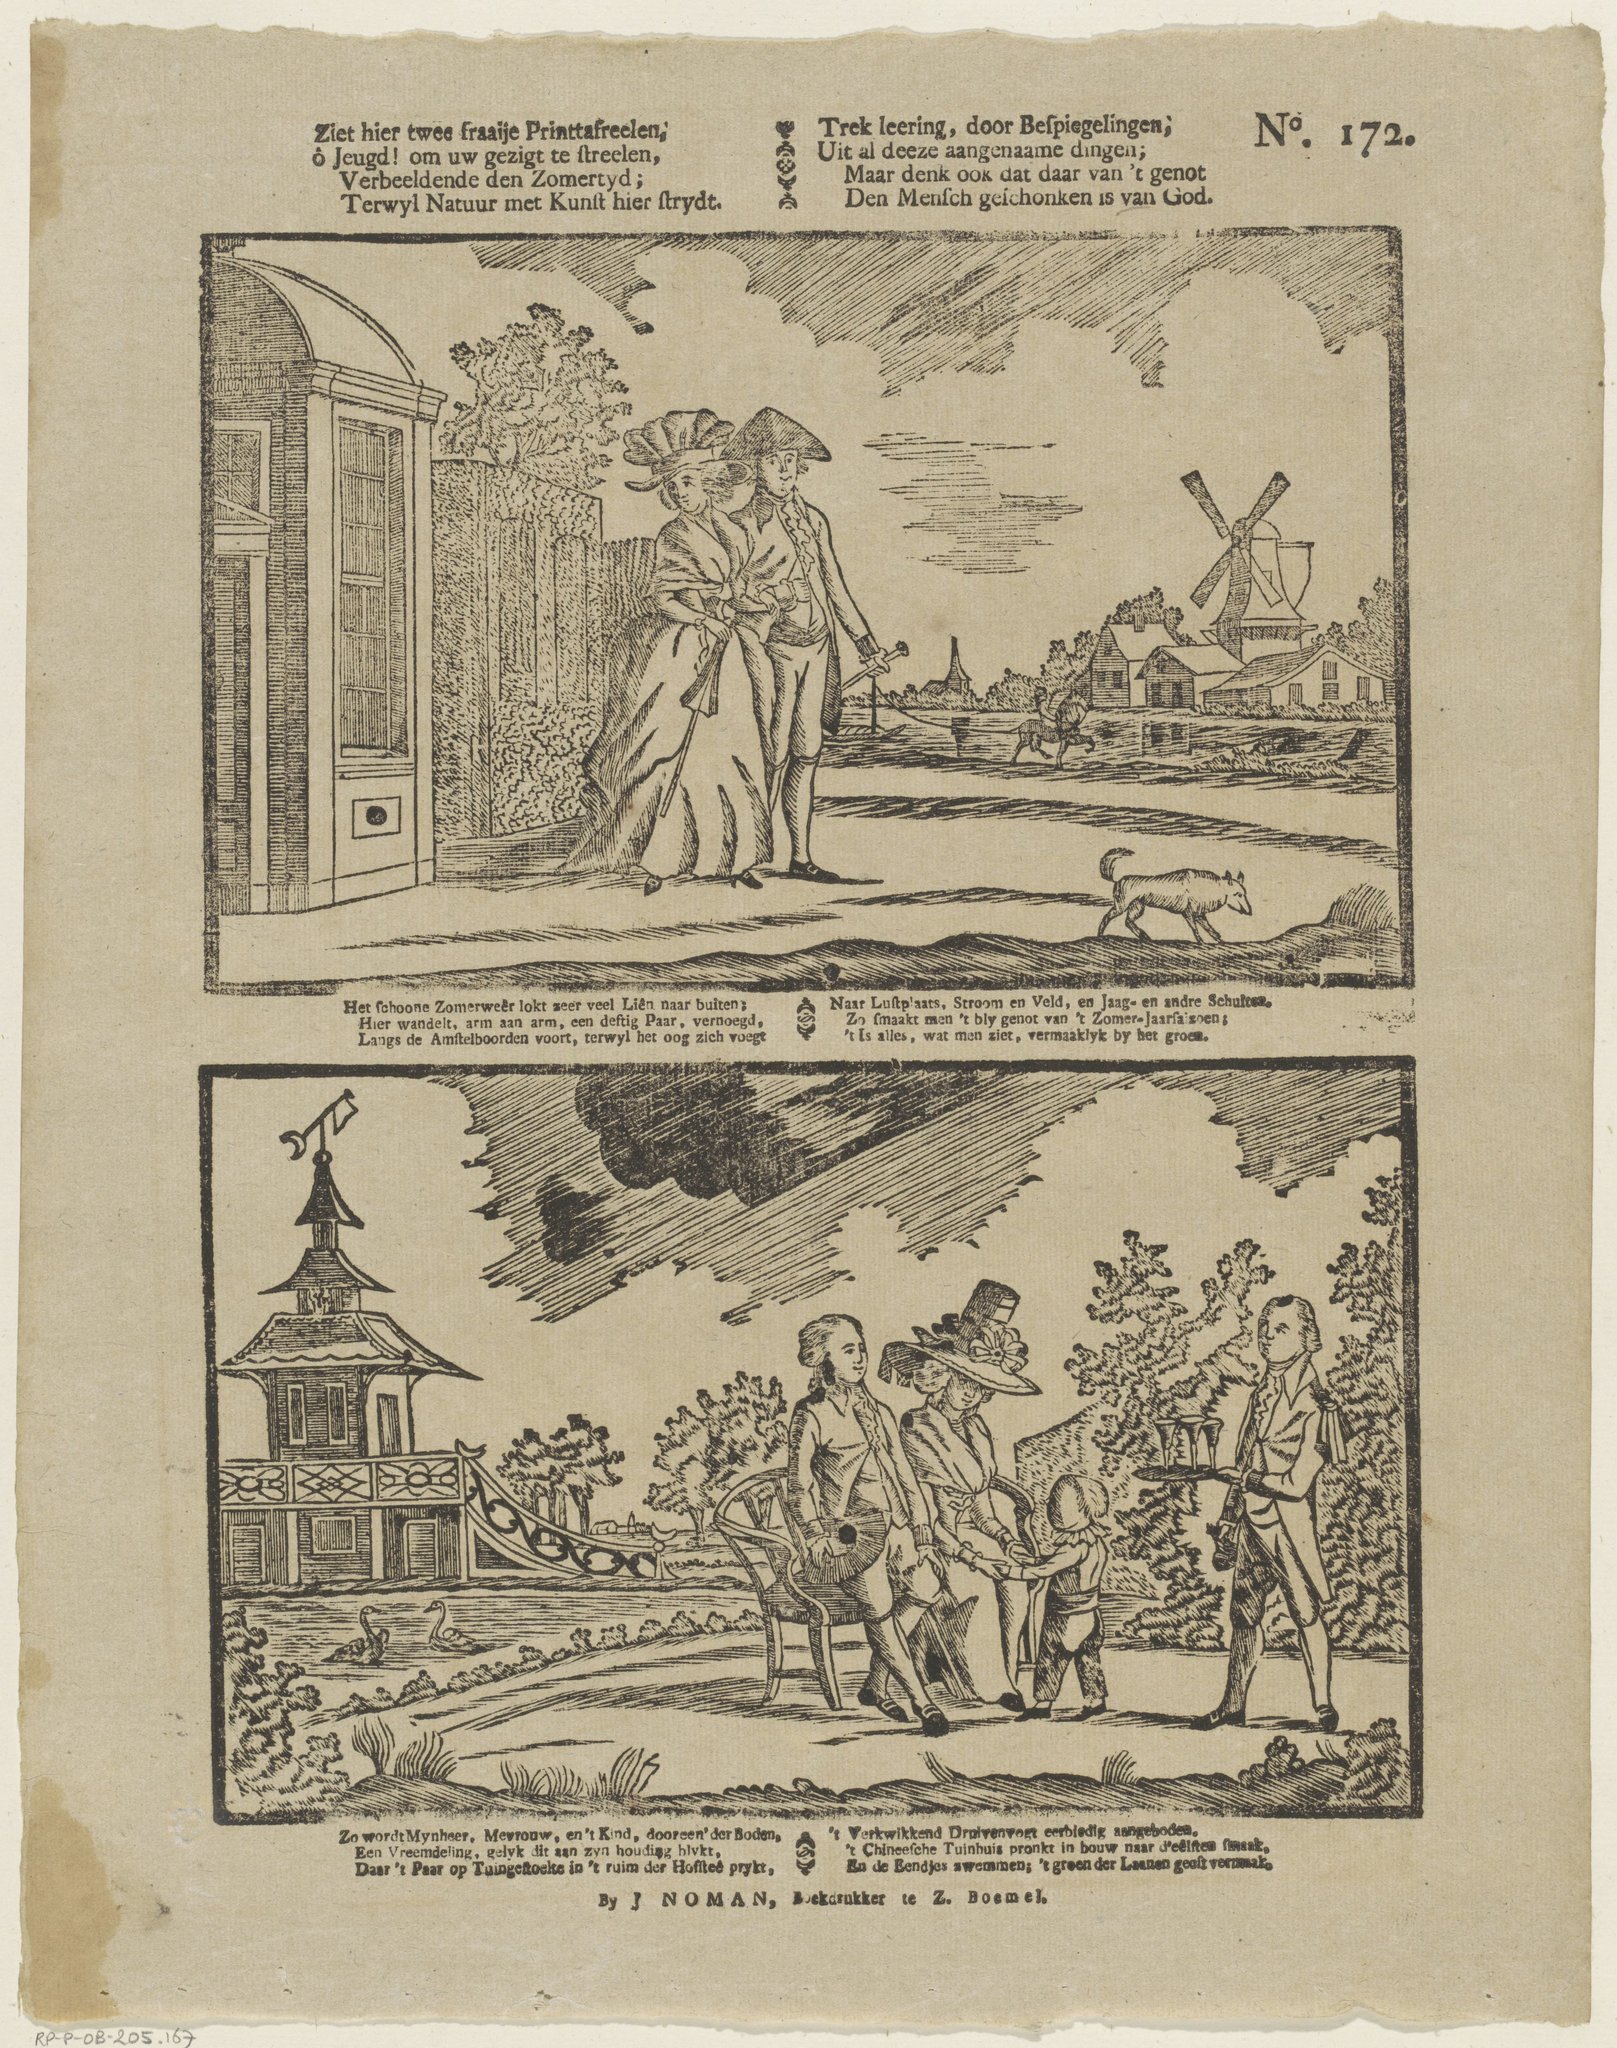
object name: print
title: Ziet hier twee fraaije printtafreelen, / ô jeugd! om uw gezigt te streelen [(...)]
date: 1806-1830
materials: paper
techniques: letterpress printing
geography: zaltbommel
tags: couple of lovers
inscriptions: collector's mark: Lugt 2760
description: Blad met 2 voorstellingen. Boven: een wandelend paar. Op de achtergrond een molen. Onder: een paar met kind zittend op een bankje. Een man rechts komt drankjes brengen. Onder elke afbeelding een zesregelig vers in twee kolommen. Genummerd rechtsboven: No. 172.